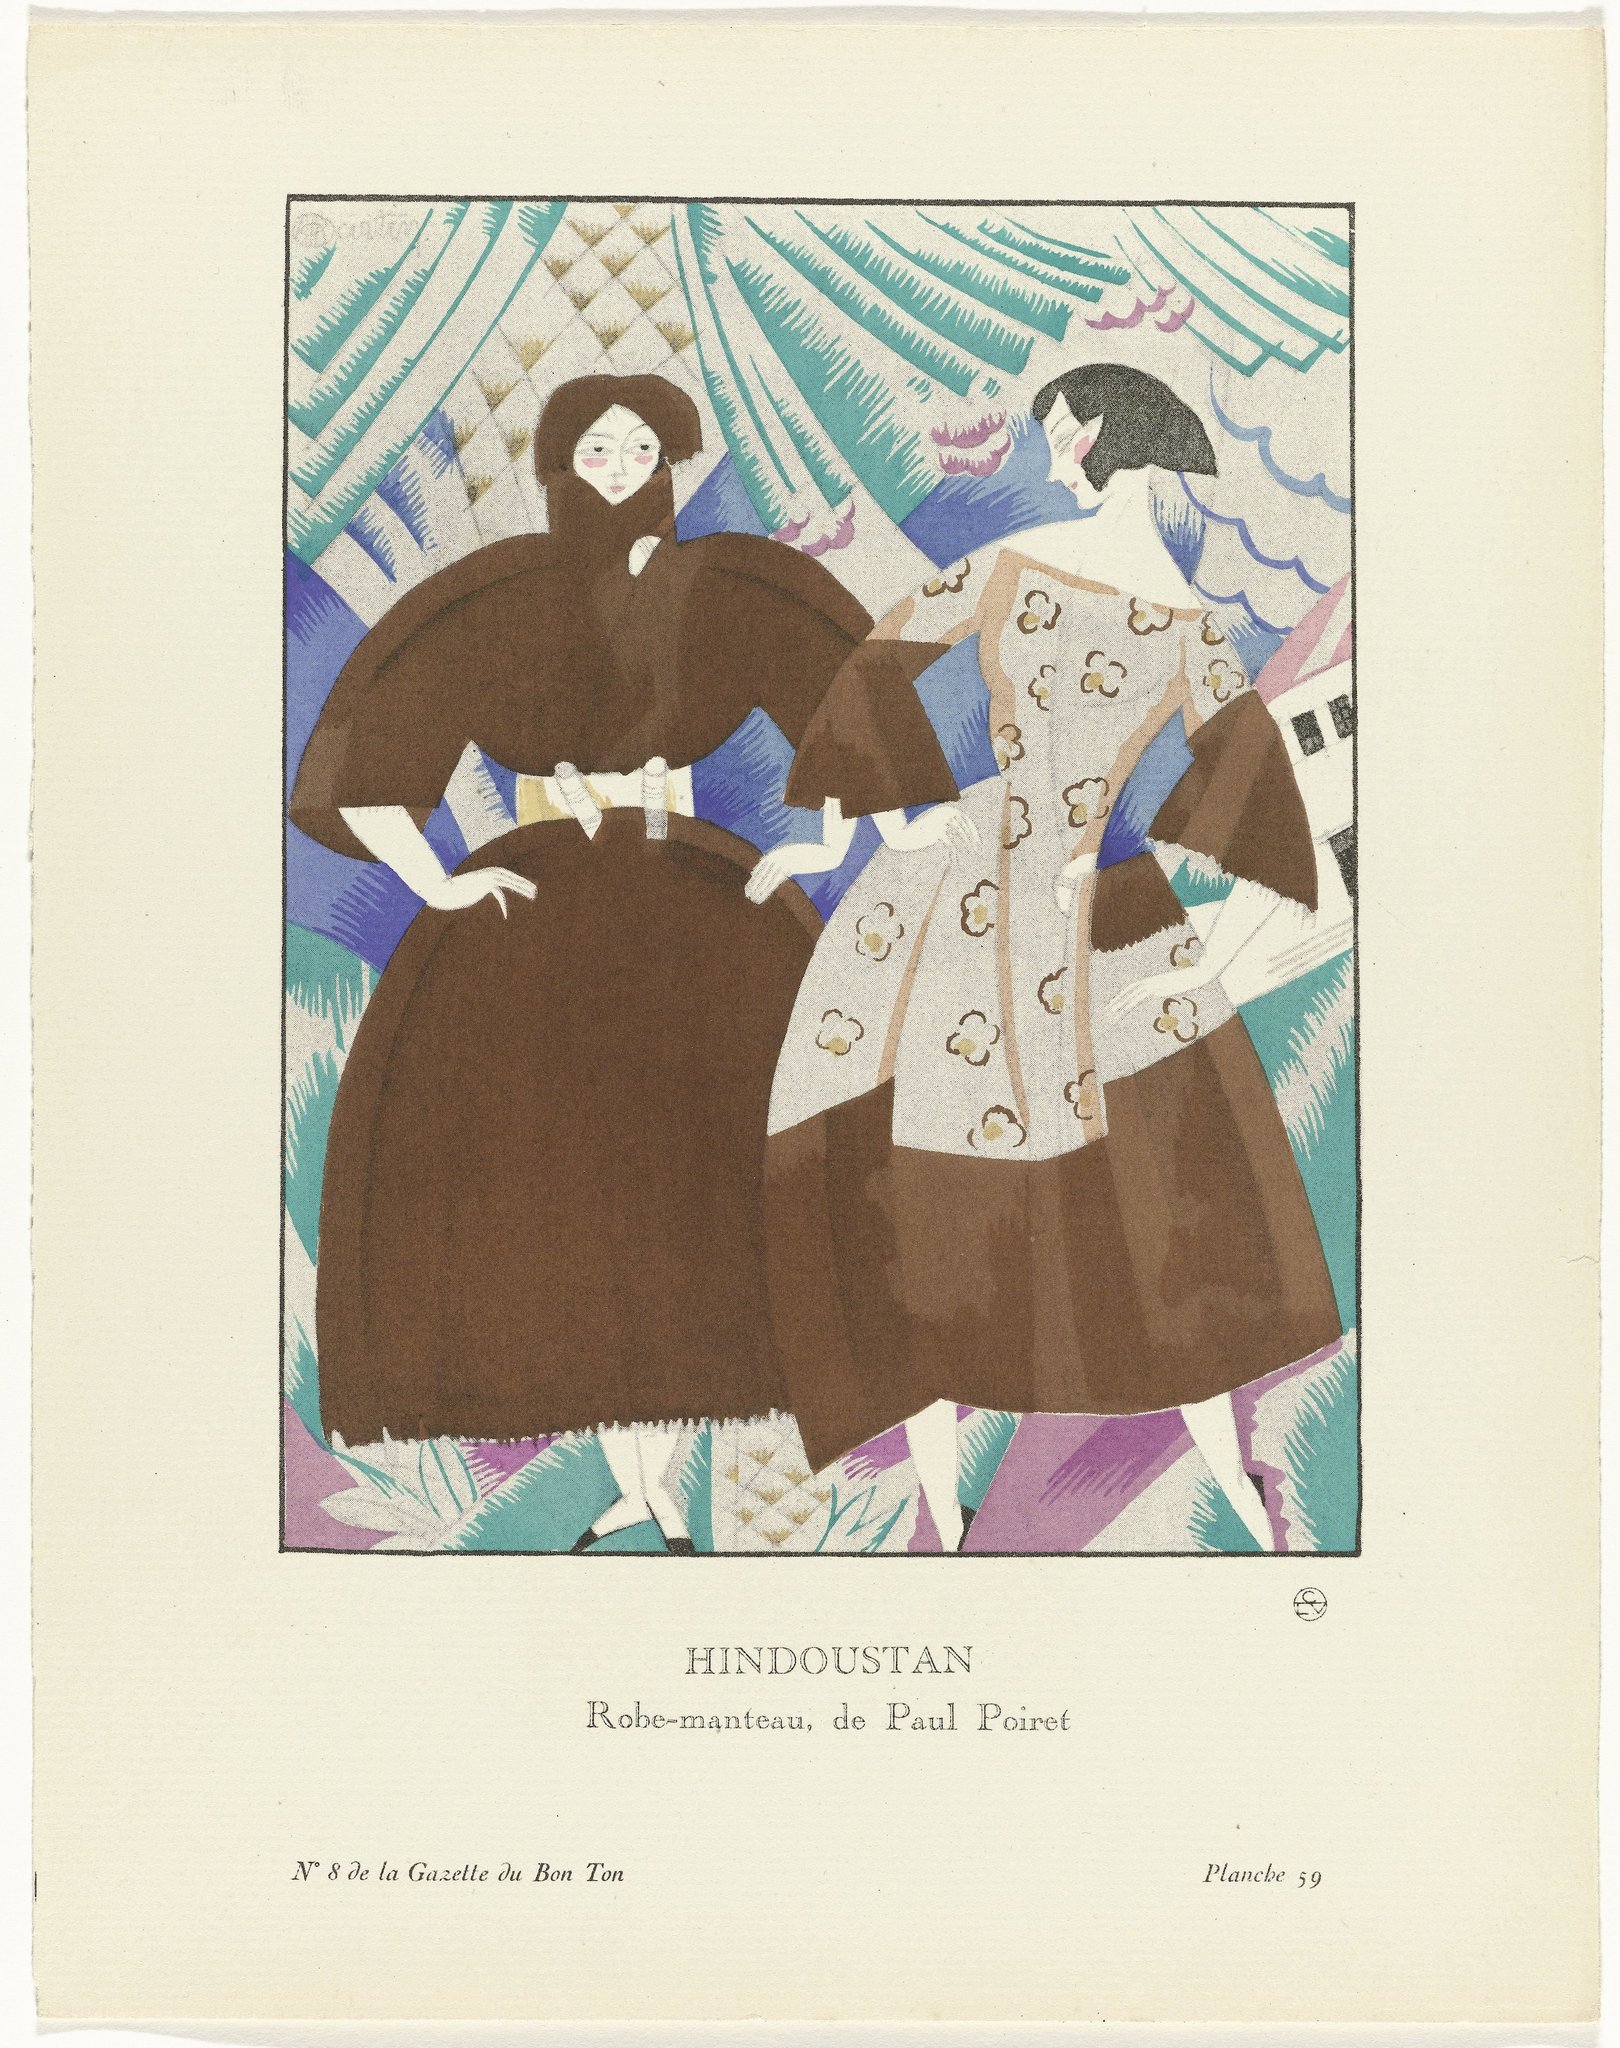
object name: fashion print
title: Gazette du Bon Ton, 1920 - No. 8, Pl. 59: Hindoustan / Robe-manteau, de Paul Poiret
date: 1920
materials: paper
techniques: hand coloring, letterpress printing, photochemical processes, pochoir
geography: paris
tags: coat (+ fur used for clothes), coat (+ women's clothes), fashion plates, dress, gown (+ women's clothes), belt, girdle, waistband (+ women's clothes)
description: Twee staande vrouwen, de linker gekleed in een bruine mantel met een leren riem, de rechter in een bruin-gouden japon met luipaard bont, beide van Paul Poiret. Planche 59 uit Gazette du Bon Ton 1920, No. 8. Uitleg over de kleding op pagina "Explication des Planches".